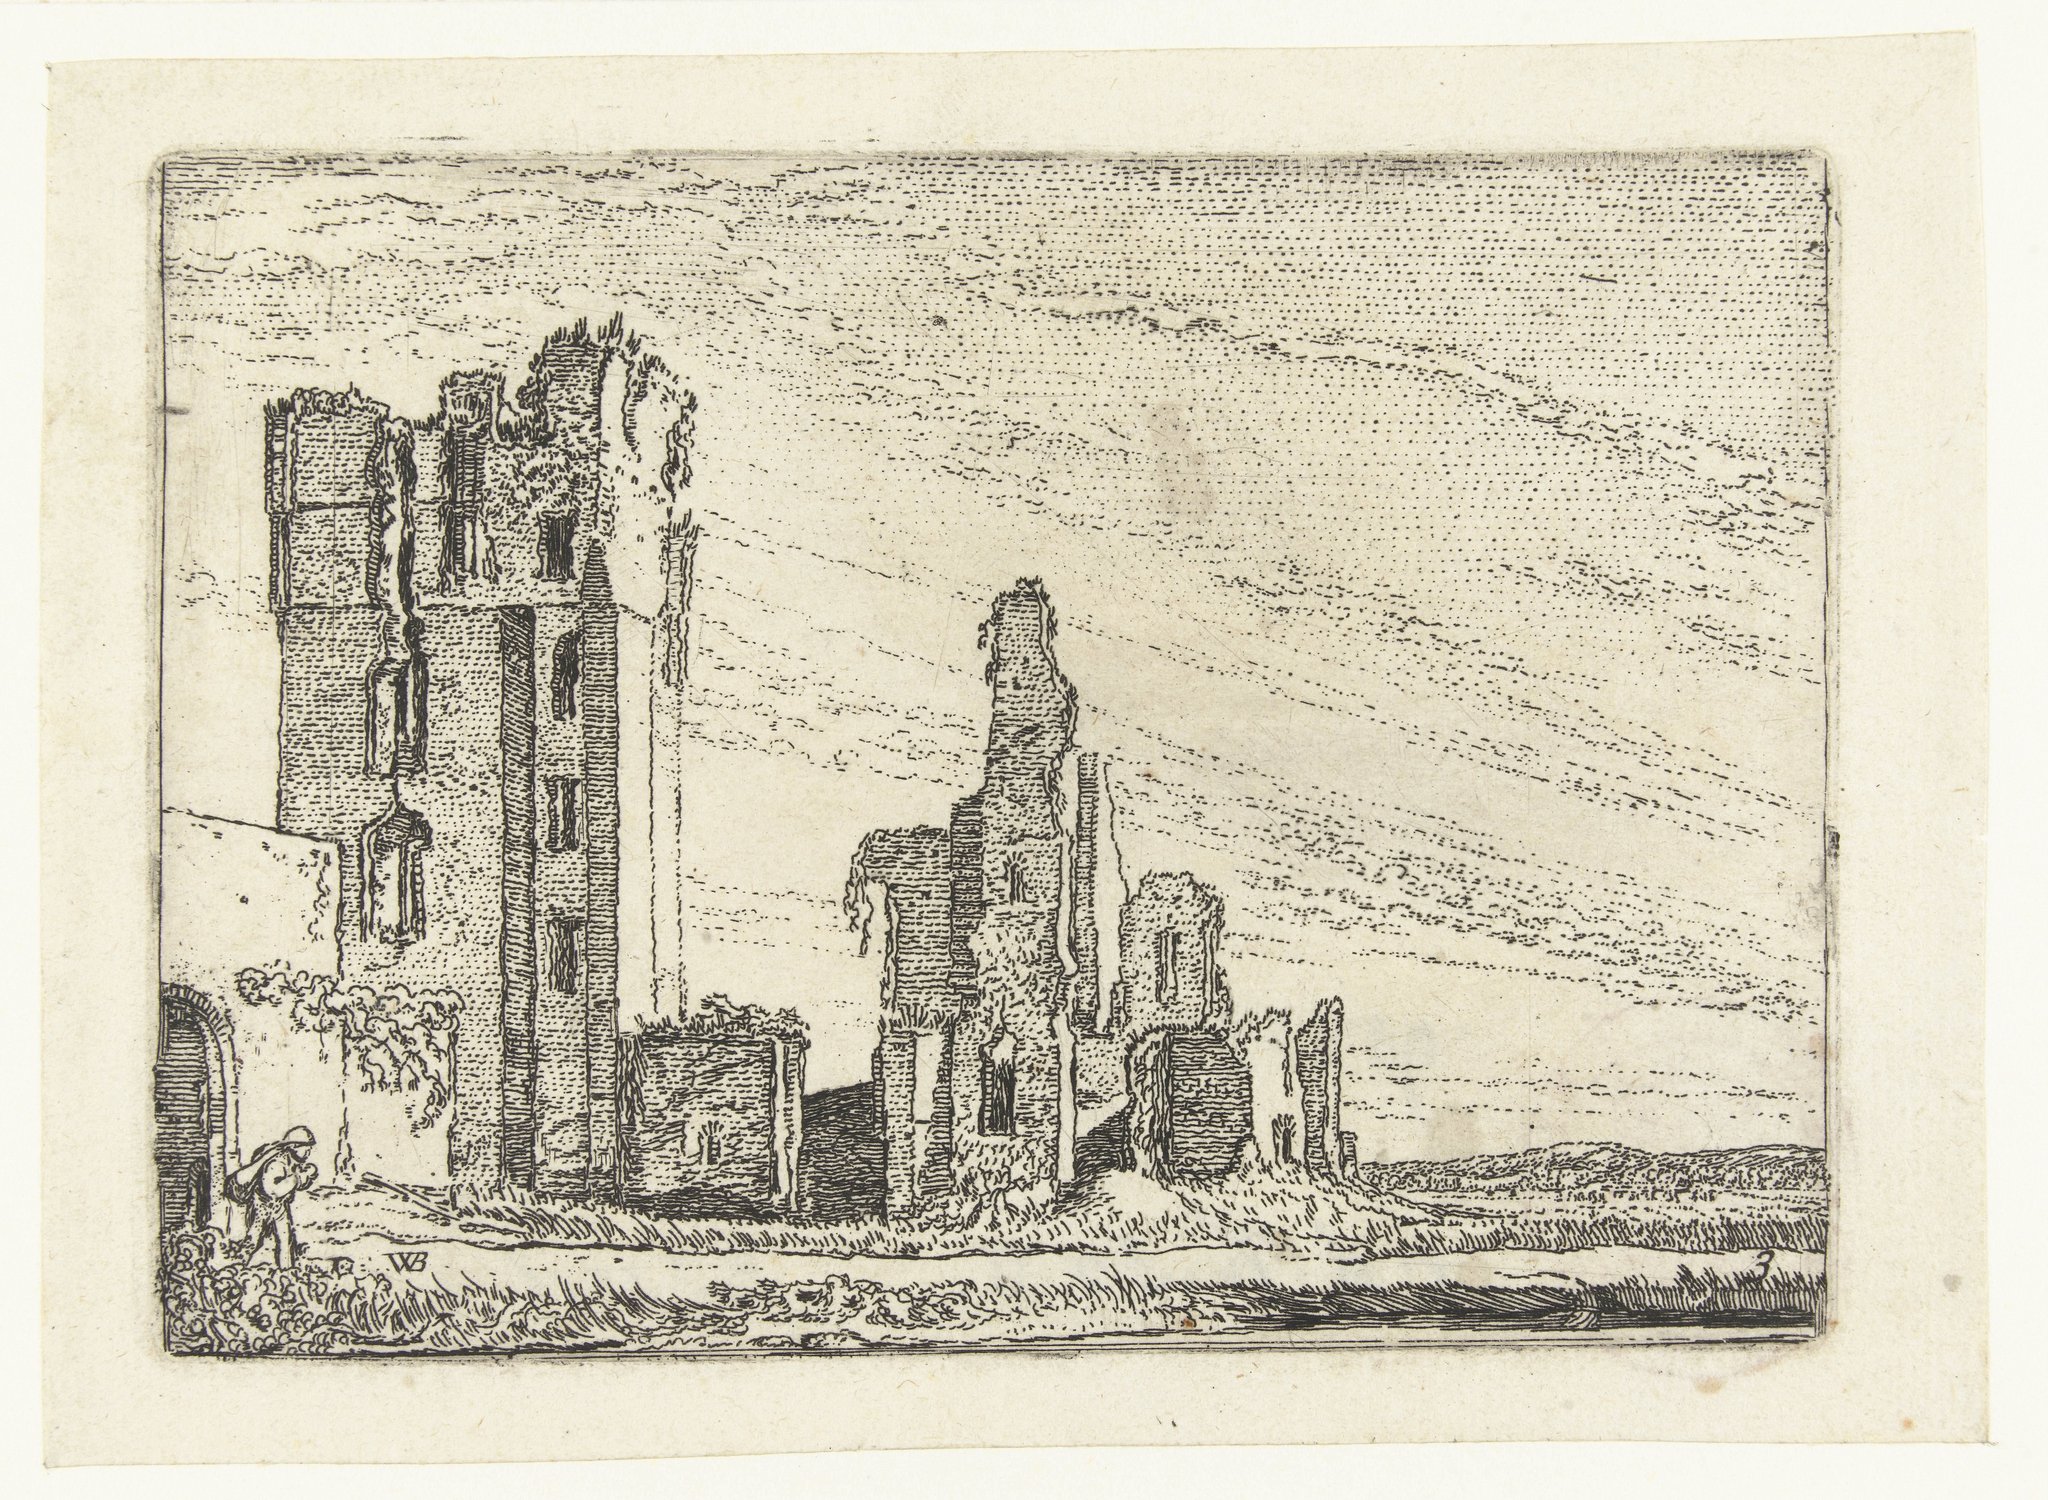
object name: print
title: Ruïnes van het Huys te Kleef bij Haarlem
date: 1621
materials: paper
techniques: etching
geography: amsterdam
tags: landscape with ruins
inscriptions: collector's mark: Lugt 240